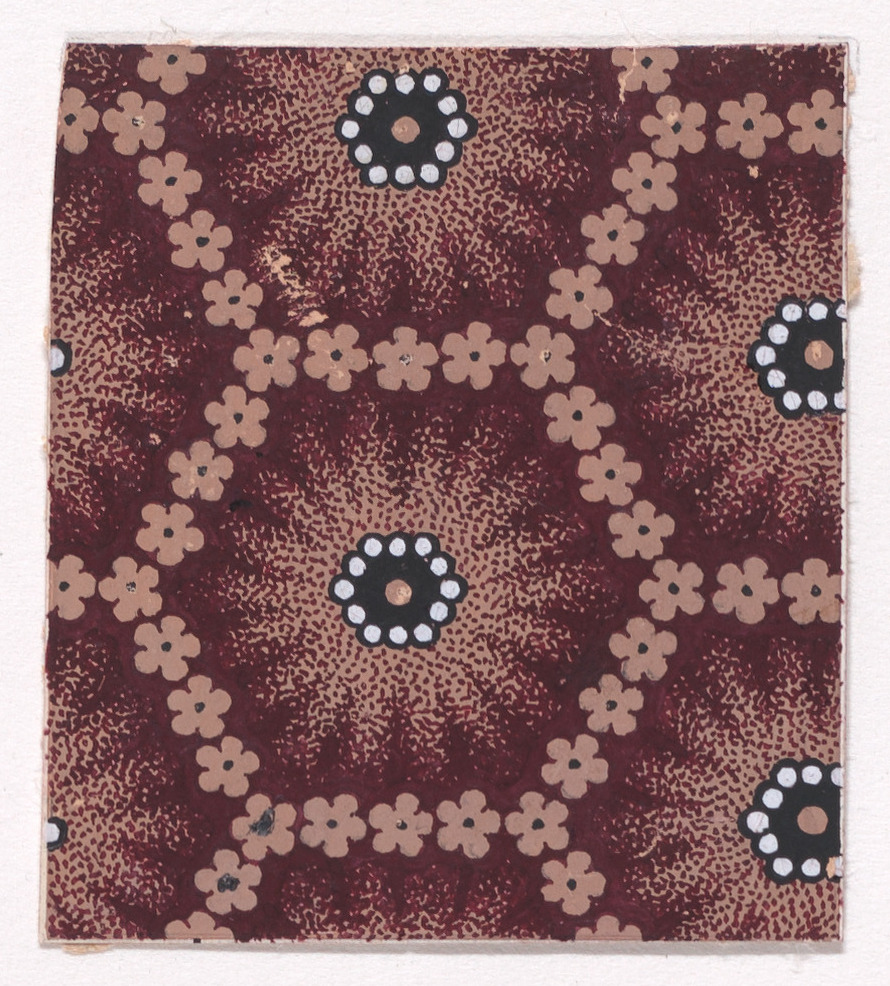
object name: drawing ornament architecture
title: Textile Design with a Honeycomb Pattern Formed with Small Rosettes and with Alternating Rows of Hexagons Decorated with Pearls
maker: anonymous, alsatian, 19th century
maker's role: artist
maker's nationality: alsatian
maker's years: 1800-1900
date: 1840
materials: gouache